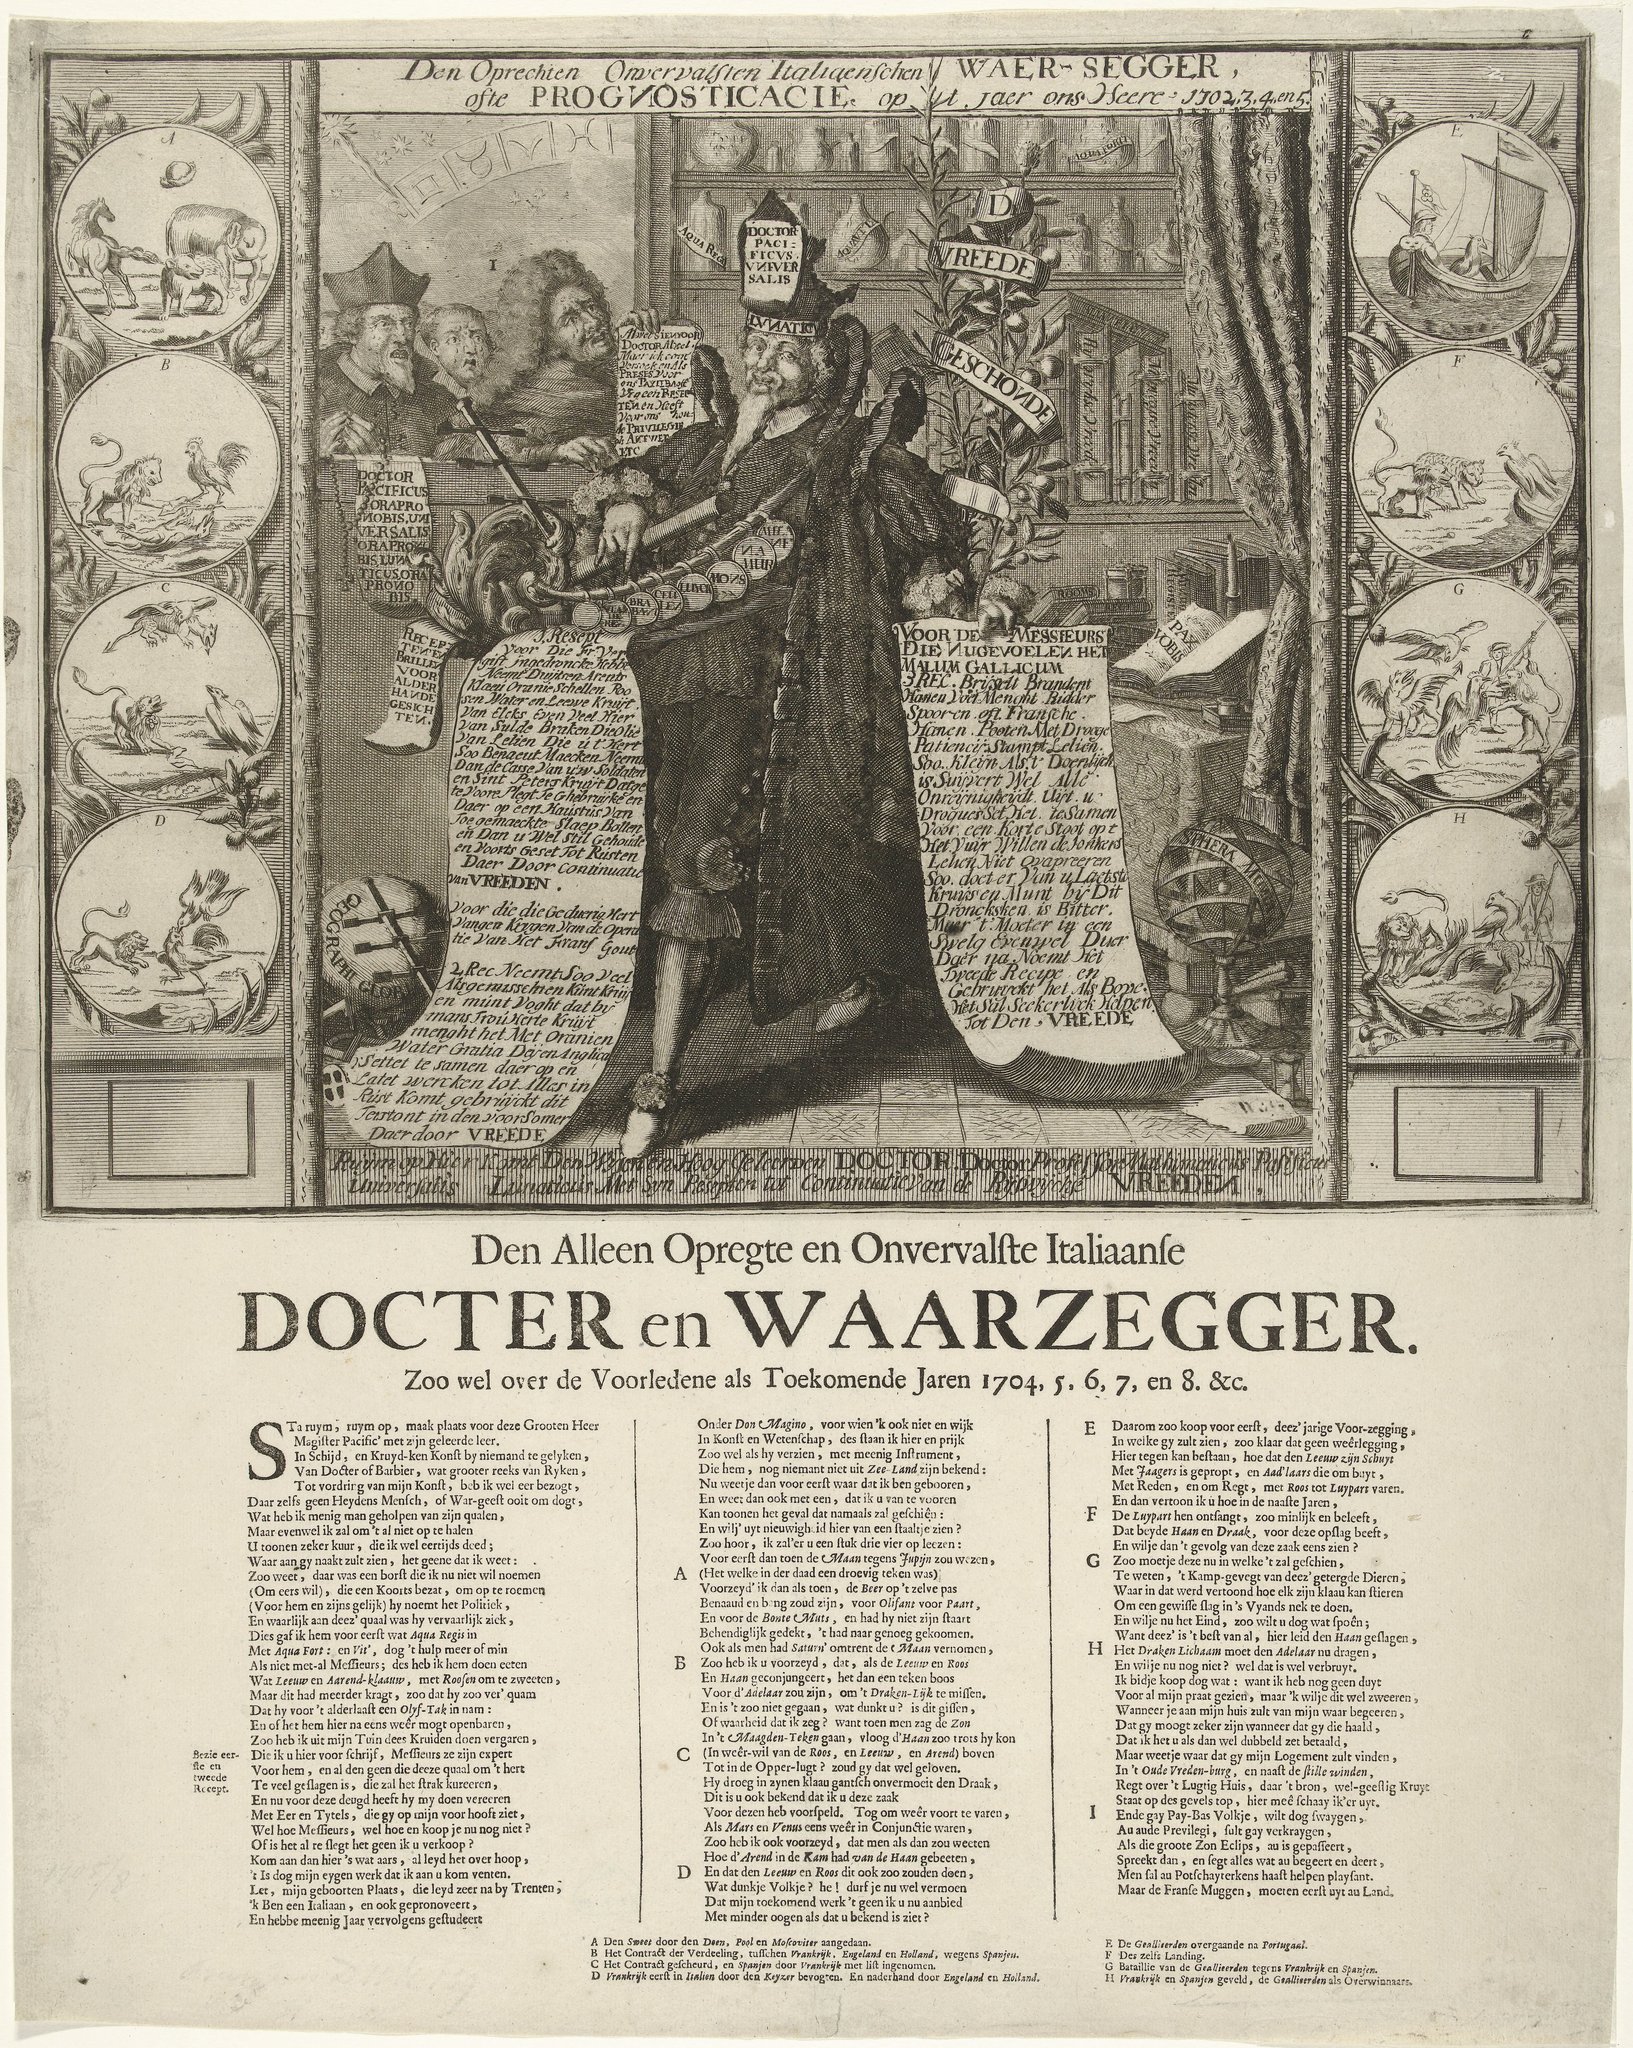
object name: print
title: Den Alleen Opregte en Onvervalste Italiaanse Docter en Waarzegger. Zoo wel over de Voorledene als Toekomende Jaren 1704, 5, 6, 7, en 8. &c.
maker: monogrammist wr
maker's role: print maker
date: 1704-1708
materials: paper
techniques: engraving, letterpress printing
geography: northern netherlands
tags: physician, doctor, fortune-teller ~ pleasure fair and circus, political caricatures and satires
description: Allegorie met de Italiaanse Waarzegger die recepten toont om te genezen van de Franse ziekte. Links kijken een jezuïet en priester verschrikt toe. Aan weerszijden acht medaillons waarin de strijd tussen Frankrijk en de geallieerden door dieren wordt verbeeld. Op het blad onder de plaat 3 kolommen tekst in het Nederlands. Onderdeel van een groep afzonderlijke spotprenten op Lodewijk XIV tijdens de Spaanse Successieoorlog, ca. 1701-1713.